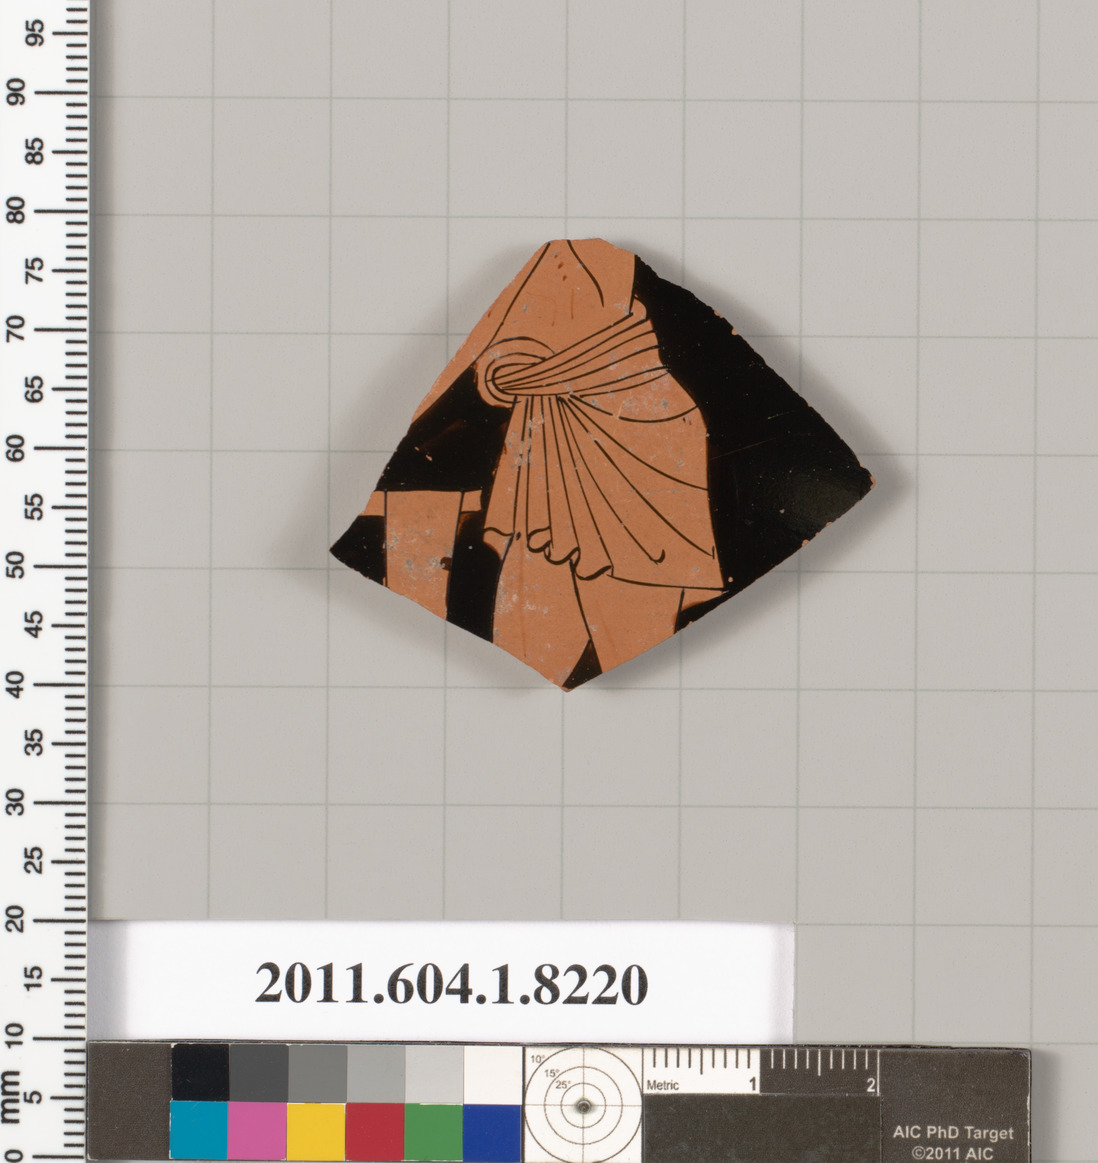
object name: kylix fragment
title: Terracotta fragment of a kylix (drinking cup)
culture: greek, attic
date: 520-510 BCE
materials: terracotta